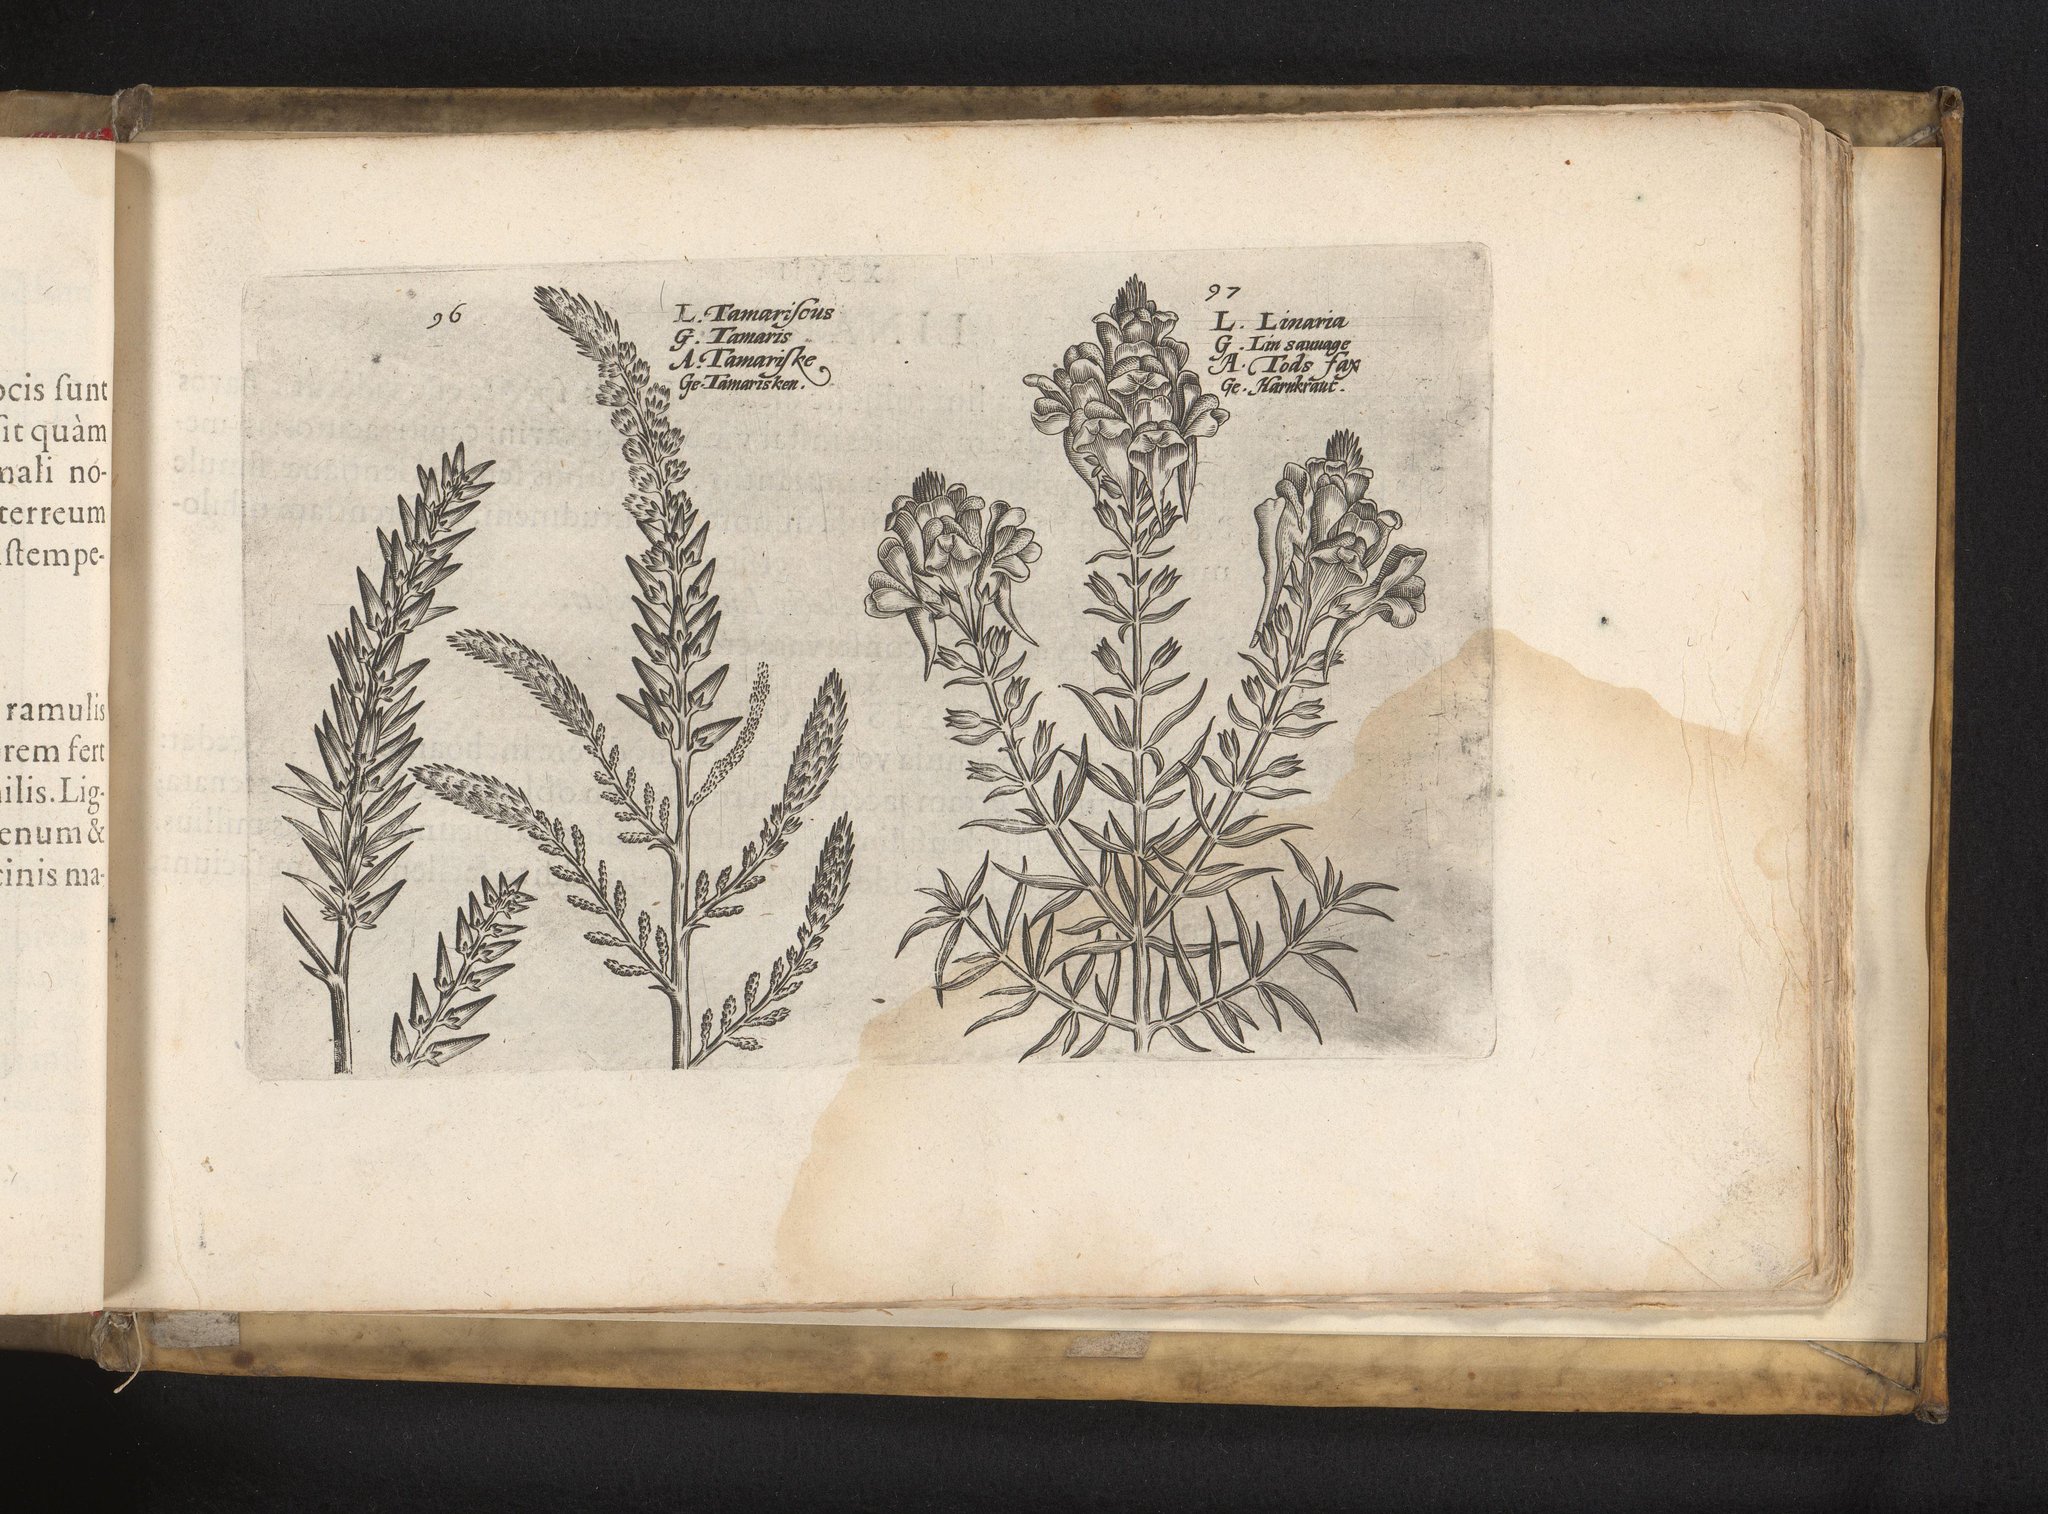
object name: book illustration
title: Hortus floridus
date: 1617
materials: paper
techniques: engraving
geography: arnhem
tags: flowers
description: Prent uit: Passe, Crispijn van de (II). Hortus floridus in quo rariorum & minus vulgarium florum icones ad vivam veramque formam. Arnhem: Johannes Janssonius, 1617.